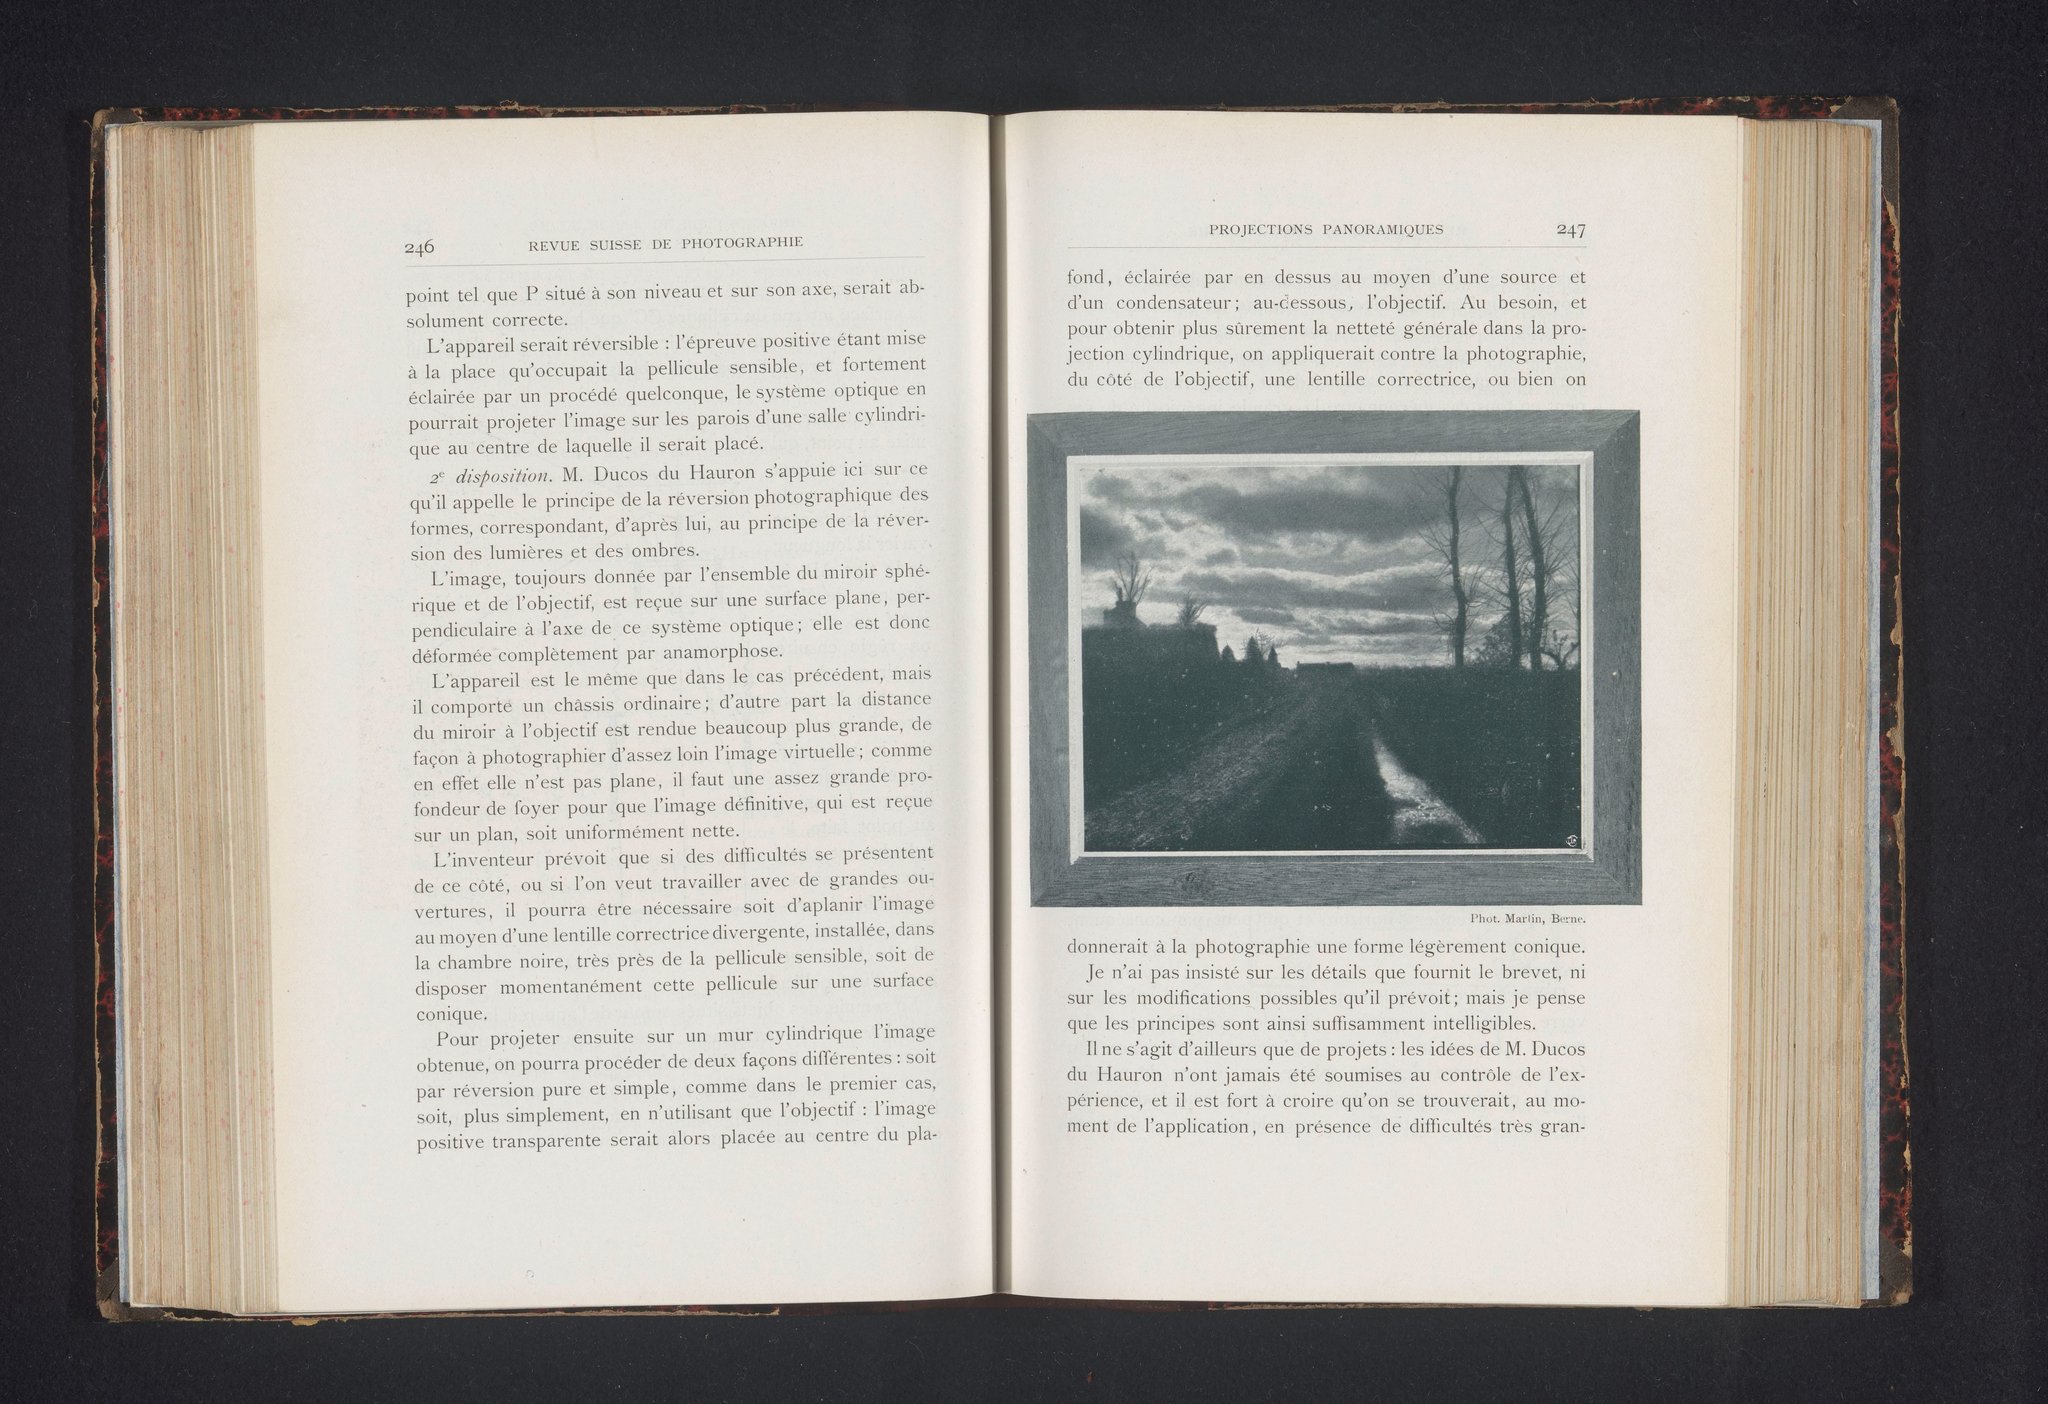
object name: photomechanical print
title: Landschap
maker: Anonymous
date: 1897-1902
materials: paper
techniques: autotype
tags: landscapes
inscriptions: inscription: ‘Phot. Martin, Berne’, monogram: ‘C. Cie’